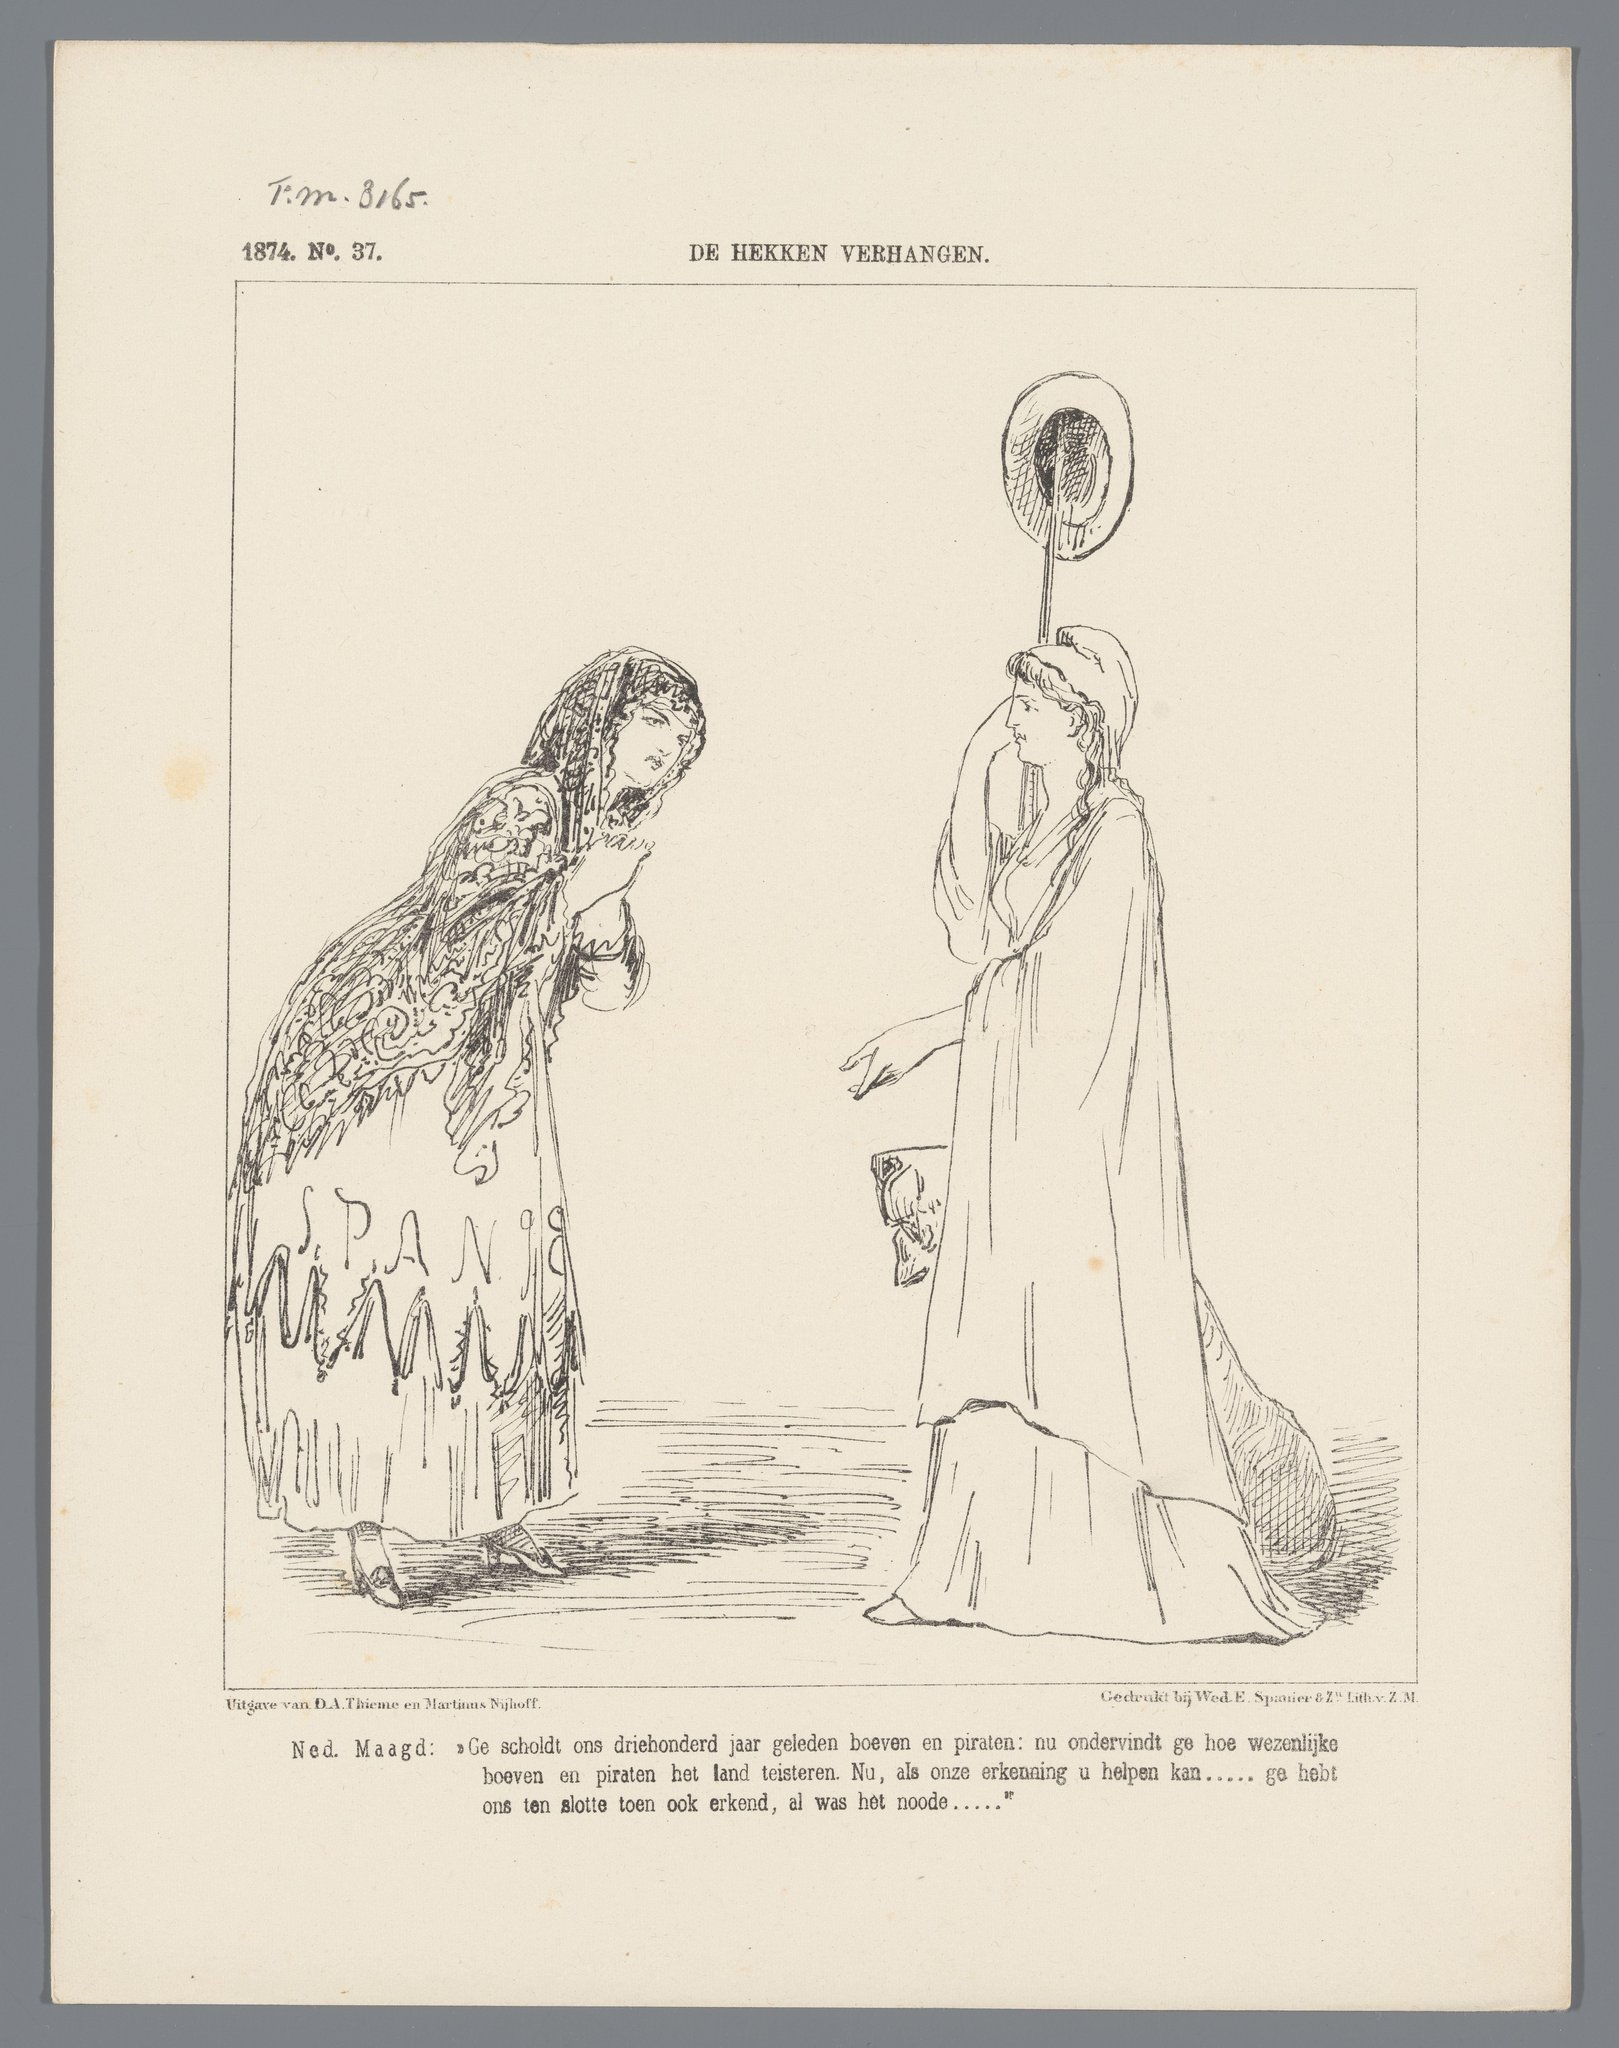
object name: cartoon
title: De hekken verhangen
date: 1874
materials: paper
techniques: lithograph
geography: netherlands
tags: spain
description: Spotprent op de erkenning van de republiek Spanje door Nederland, 1874. Plaat verschenen bij het weekblad De Nederlandsche Spectator, nr. 37, 1874.